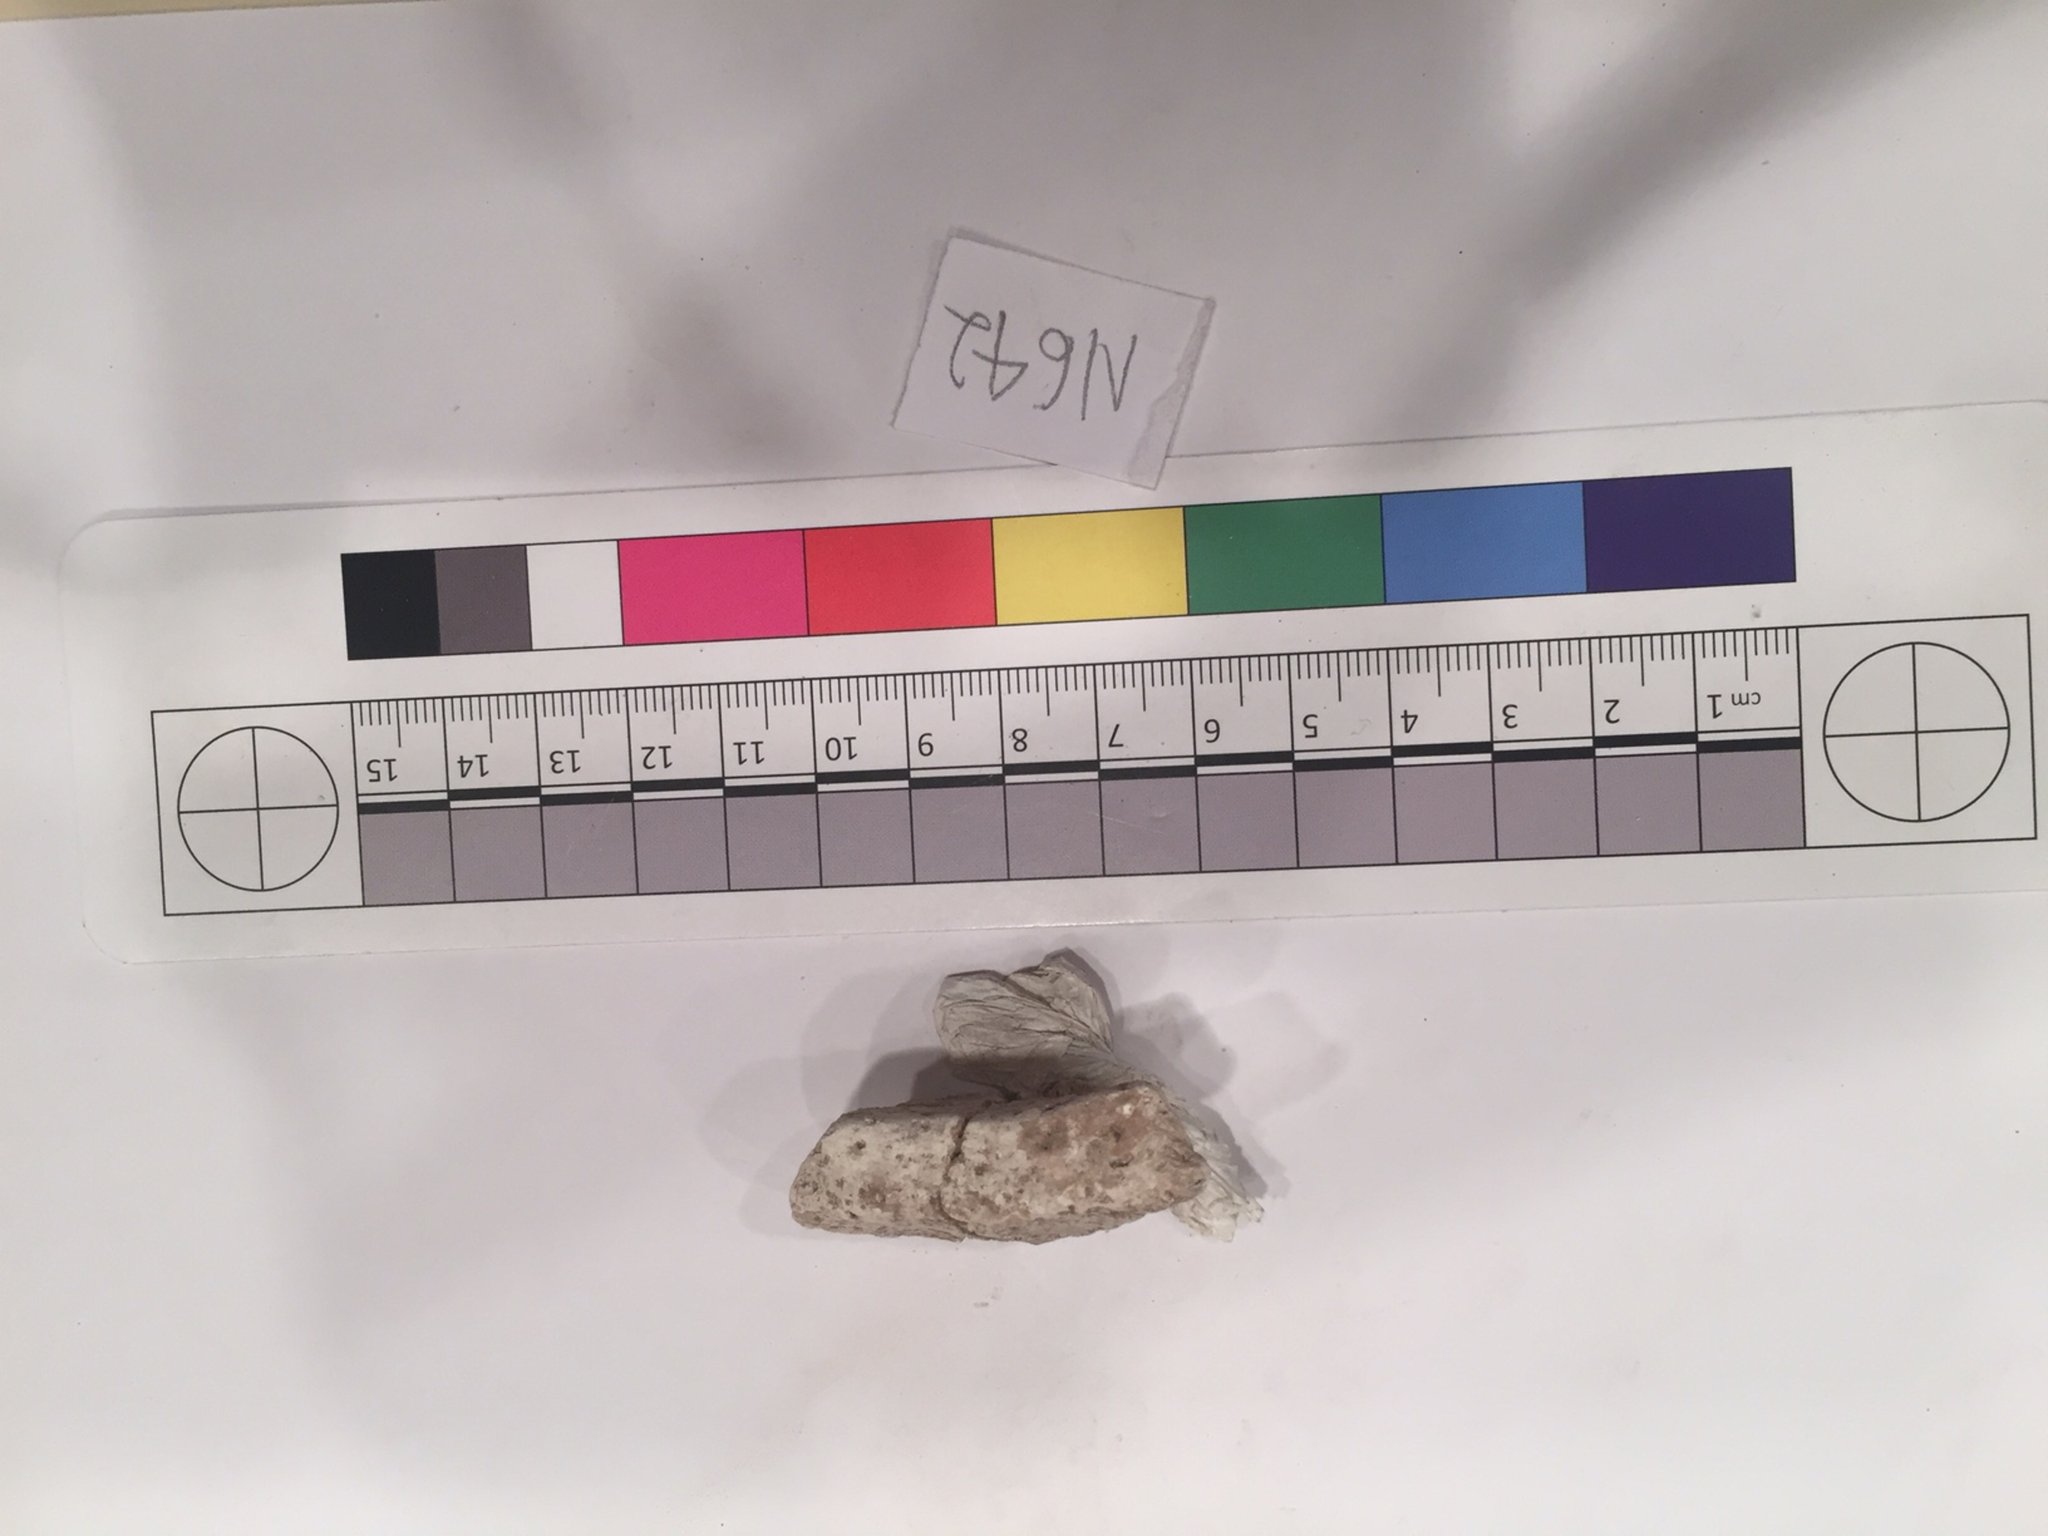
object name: fragment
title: Stucco Fragment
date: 701-1200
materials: plaster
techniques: carving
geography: iran